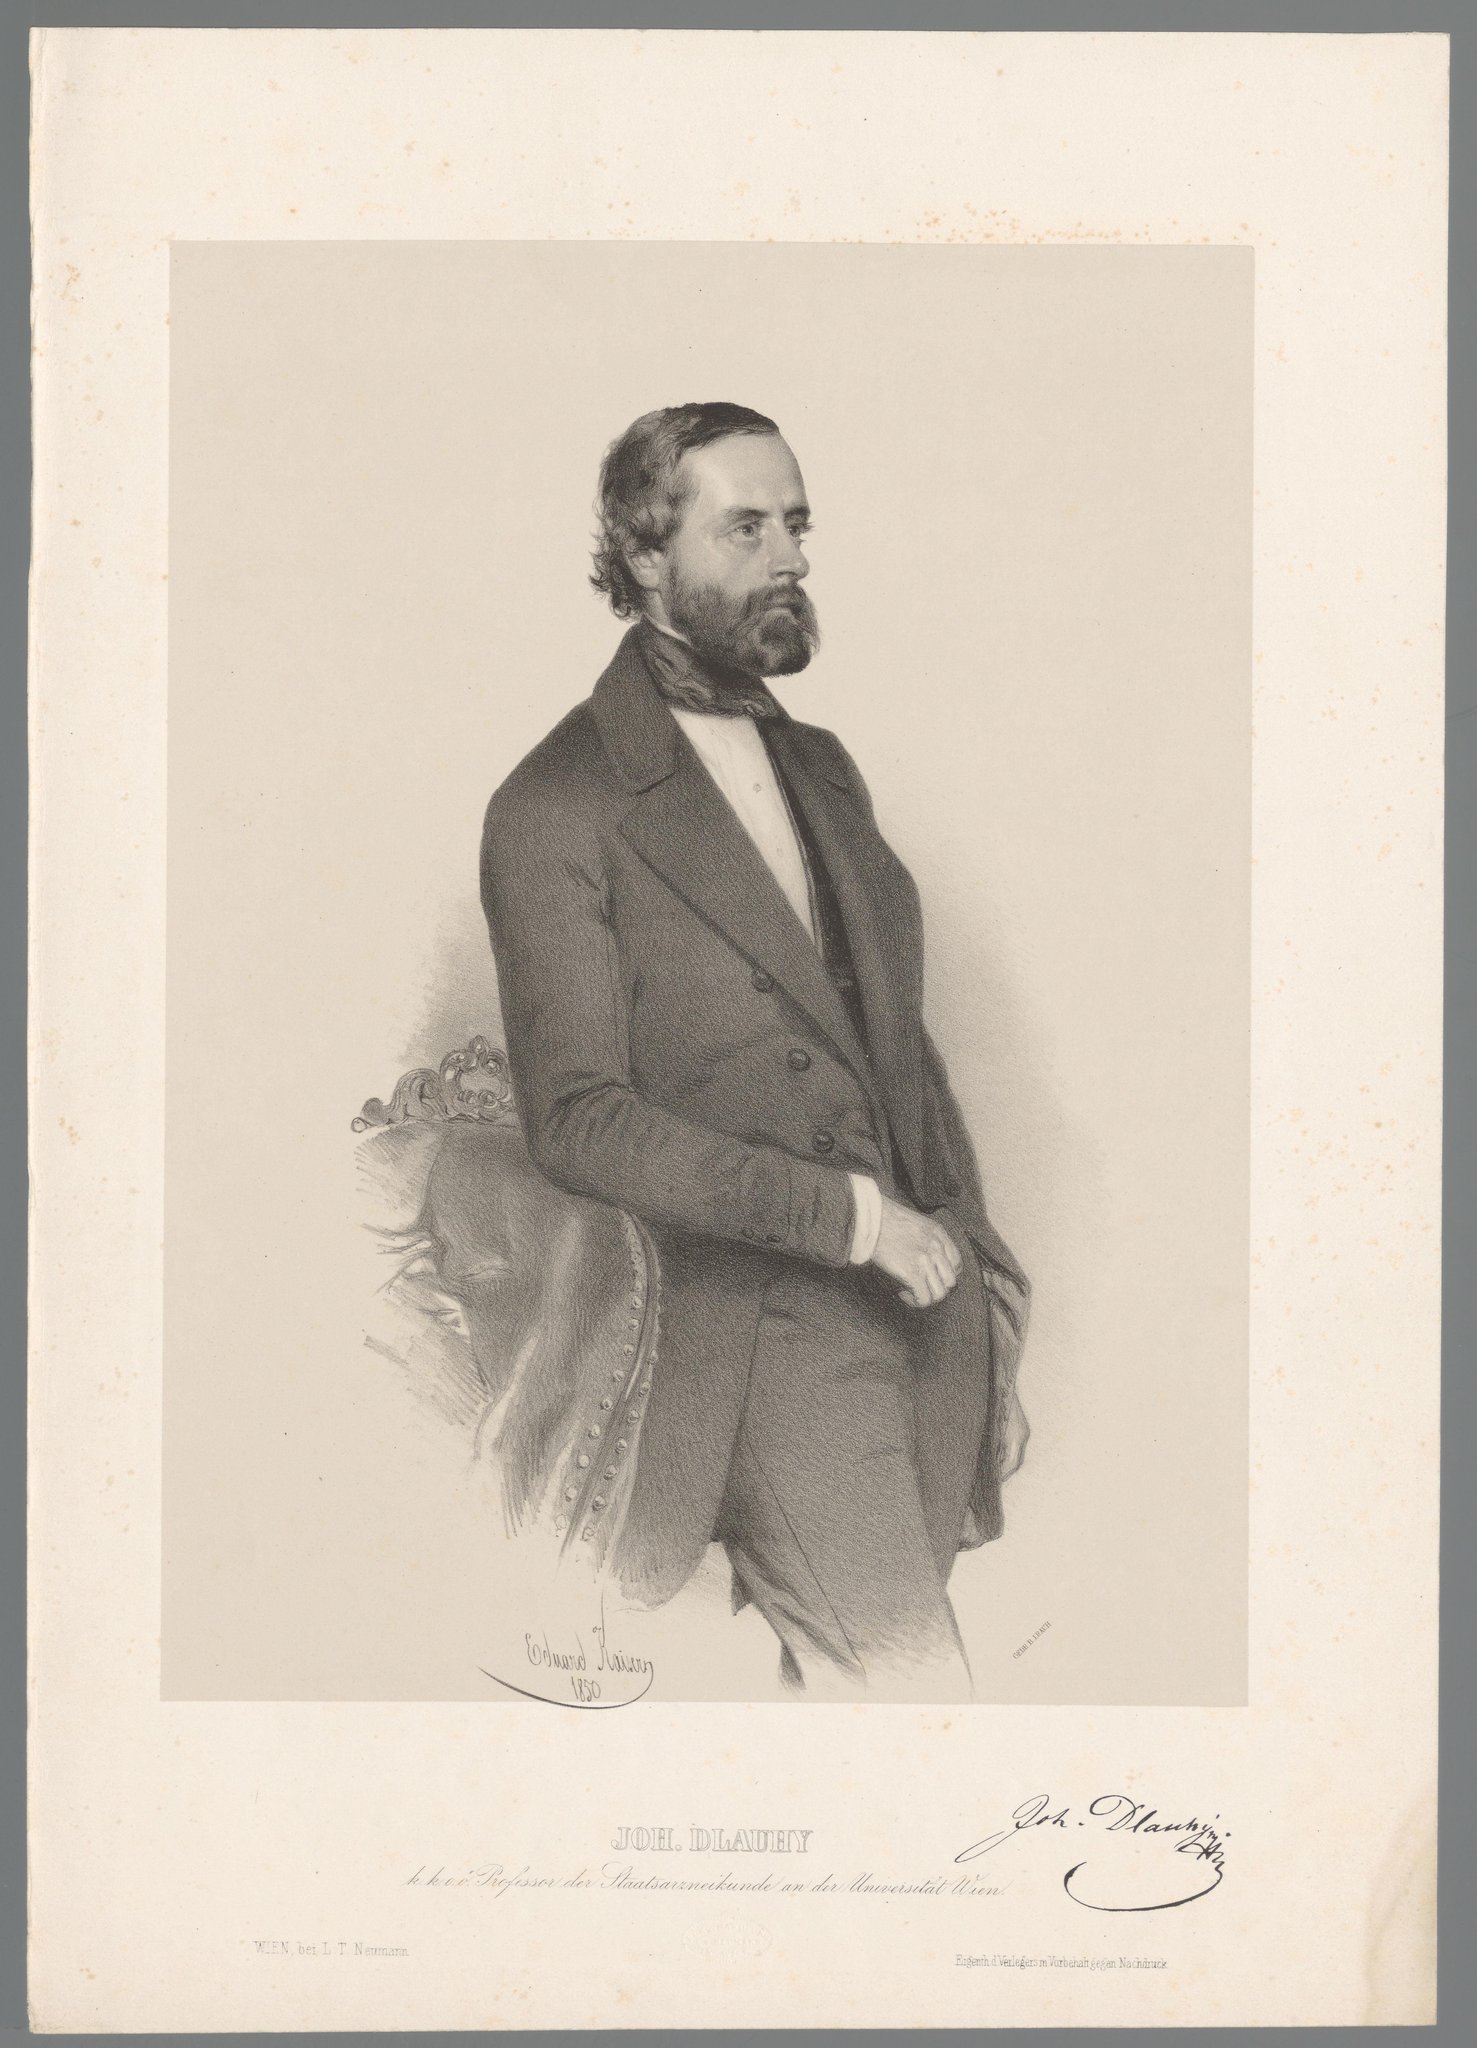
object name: print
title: Portret van Johann Nepomuk Dlauhy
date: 1850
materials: paper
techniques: lithograph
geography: vienna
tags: adult man, historical persons, beard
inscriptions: collector's mark: Lugt 2228, check stamp: ‘Kunsthandlung le Neumann in Wien’